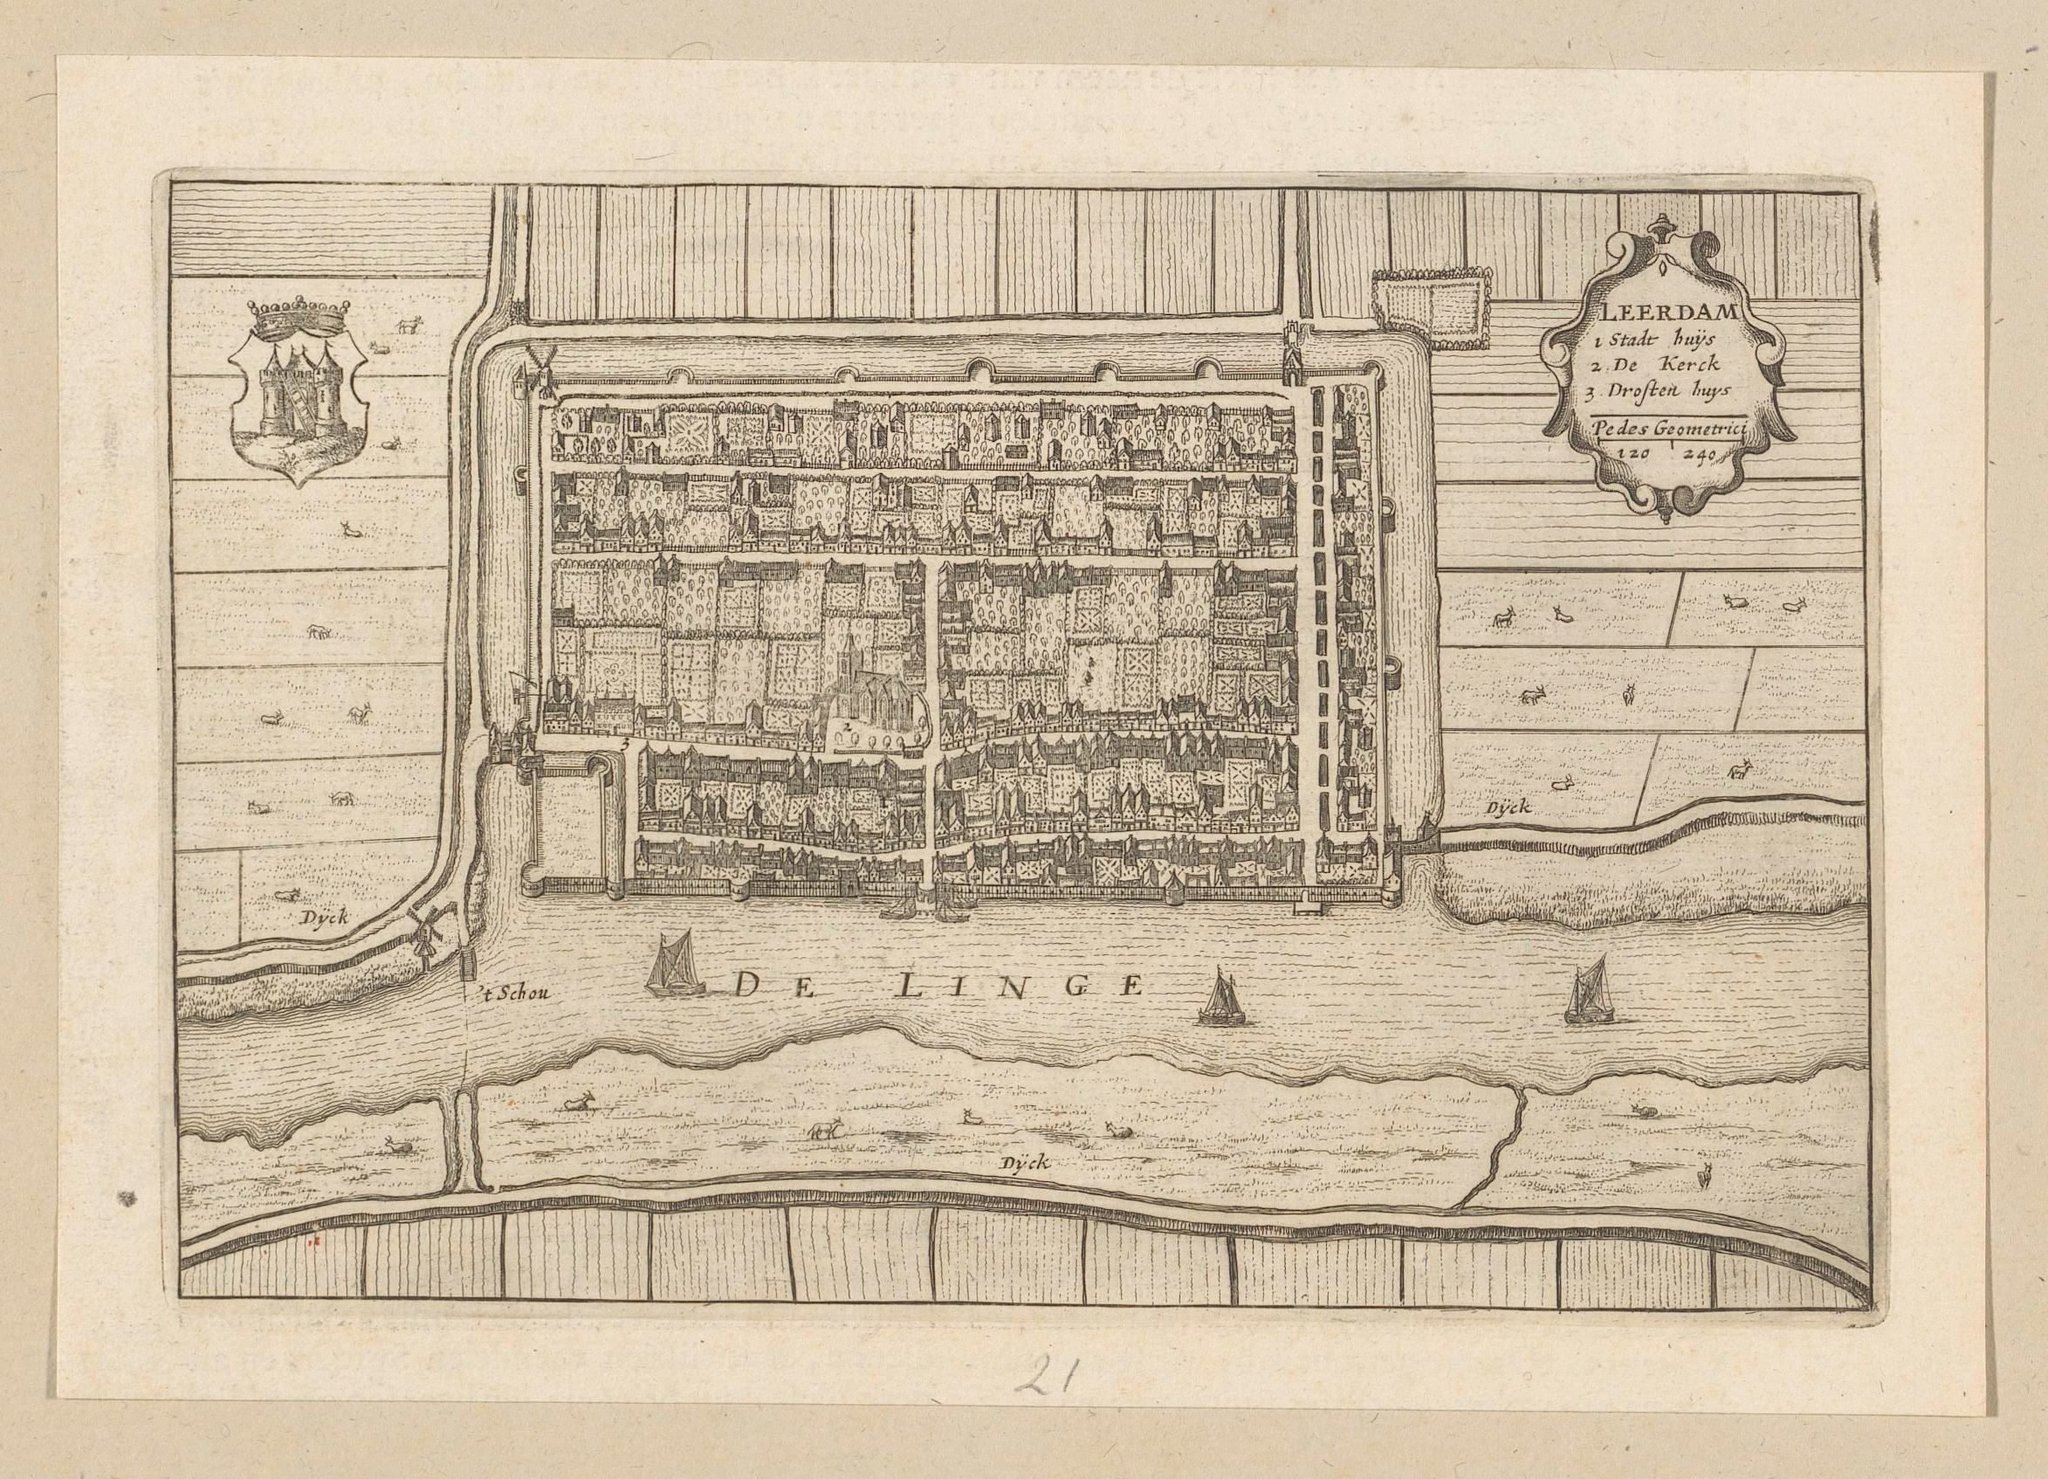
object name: print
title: Leerdam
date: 1632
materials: paper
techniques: engraving, etching, letterpress printing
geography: amsterdam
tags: coat of arms (as symbol of the state, etc.) (+ city; municipal), maps of cities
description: Prent gebruikt in: Blaeu, Johannes Willemszoon. Toonneel der steden van de Vereenighde Nederlanden. 2 delen. Amsterdam: Johannes Willemszoon Blaeu, 1652, dl. 1. Prent voor het eerst ook gebruikt in: Boxhorn, Marcus Zuerius van. Theatrum sive Hollandiae comitatus et urbium nova descriptio (…). Amsterdam: Henricus Hondius, 1632.